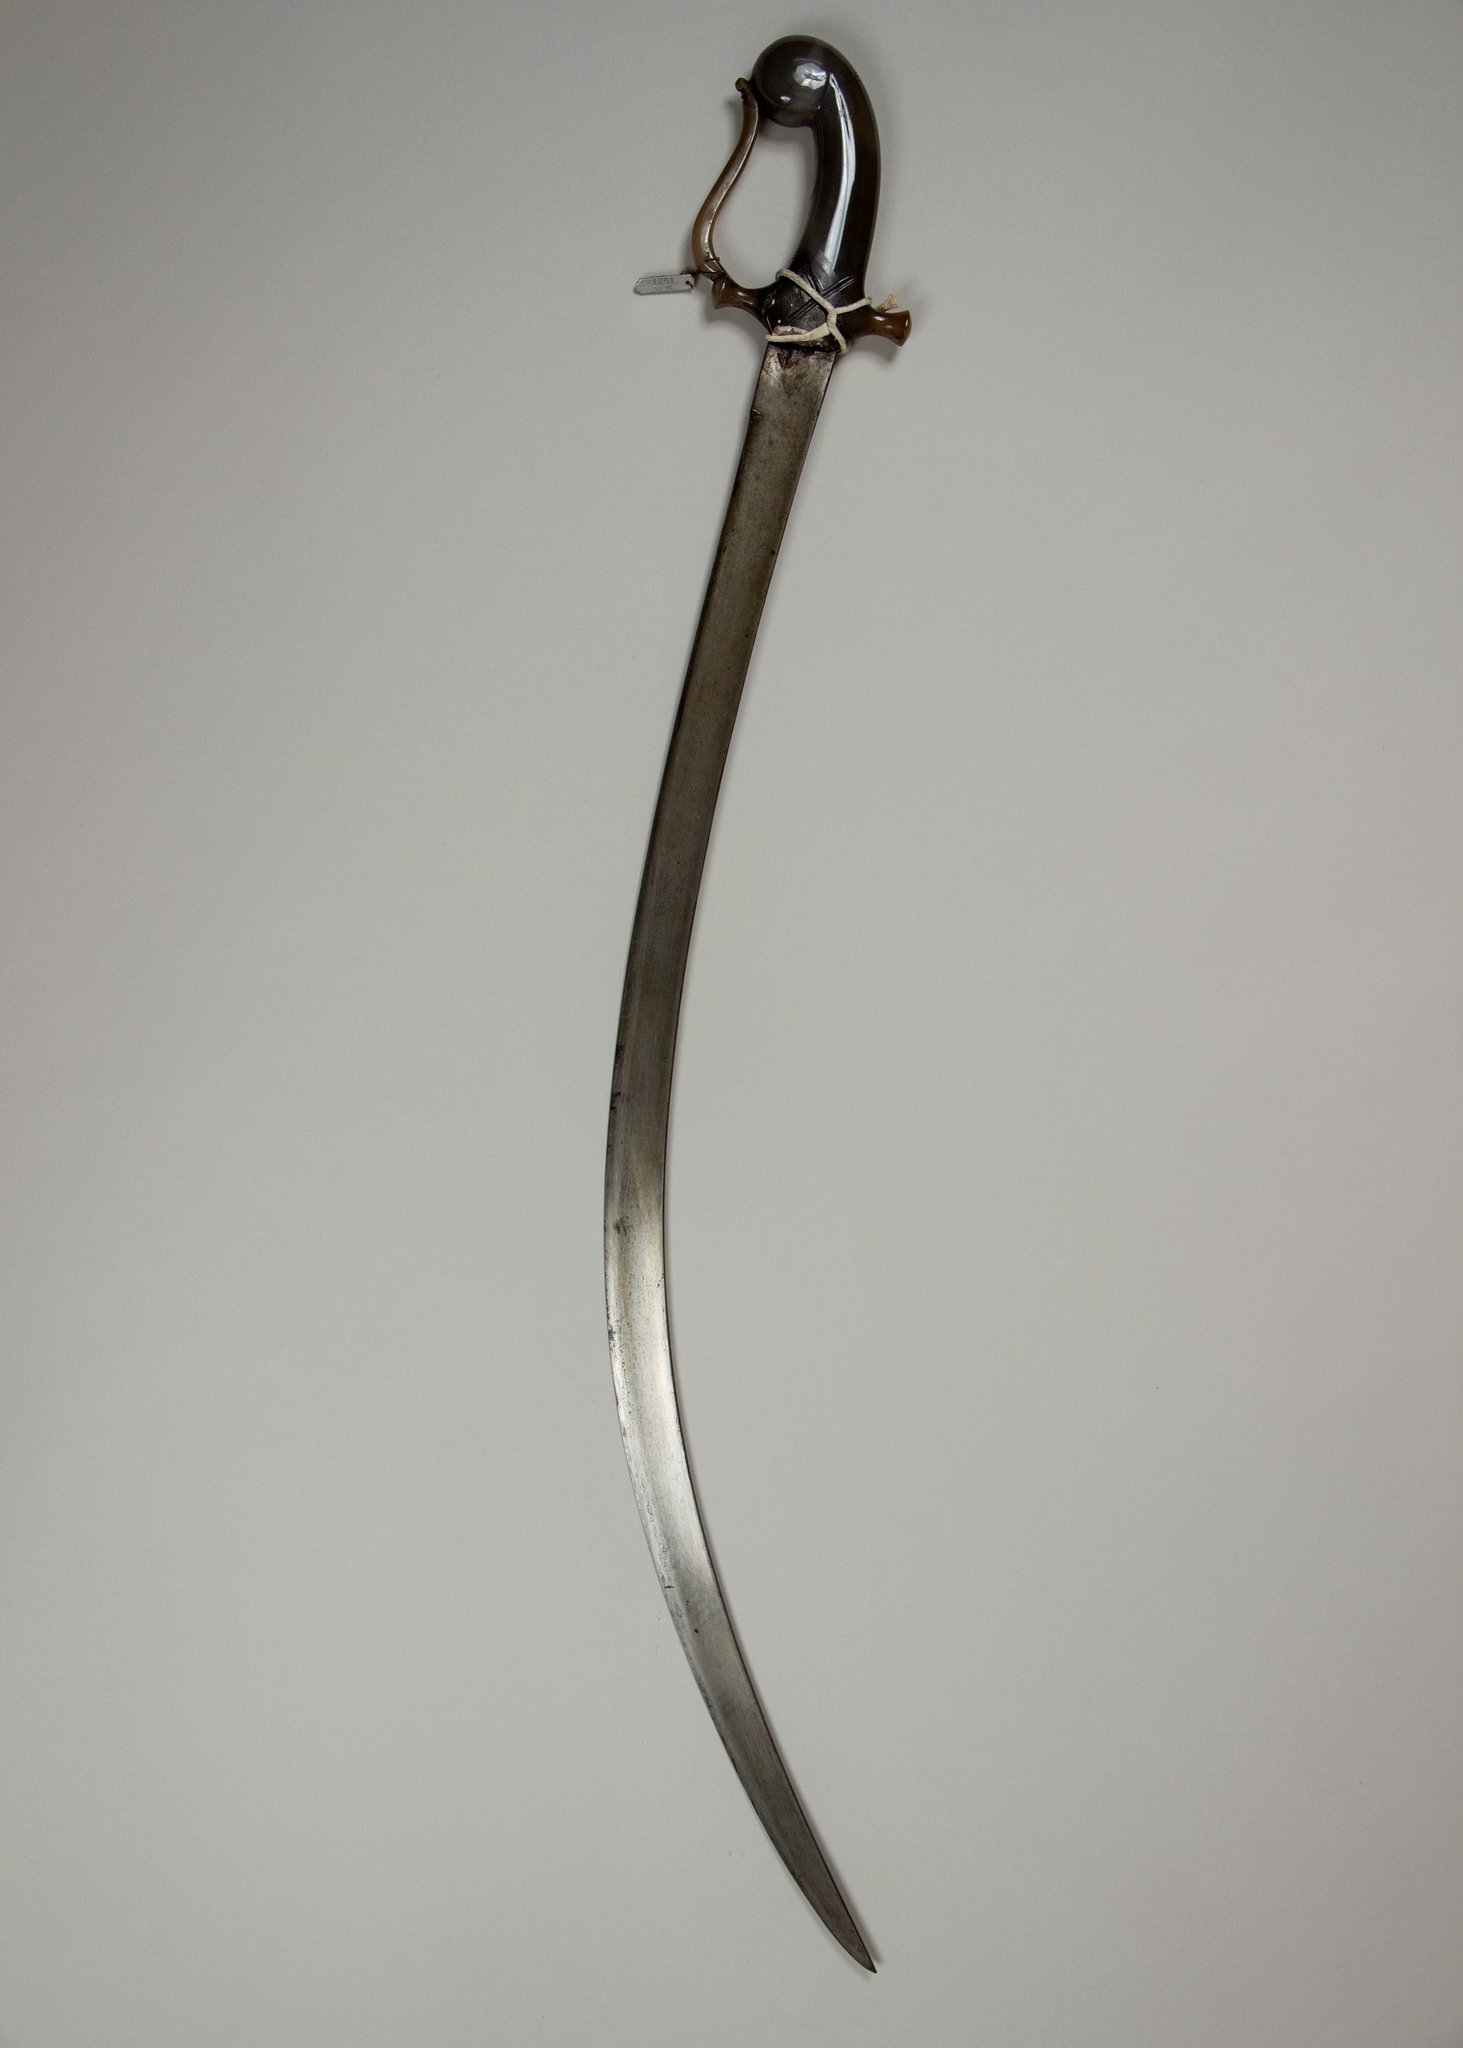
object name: sword shamshir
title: Sword (Shamshir)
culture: indian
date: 1801-1900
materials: stone, steel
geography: india